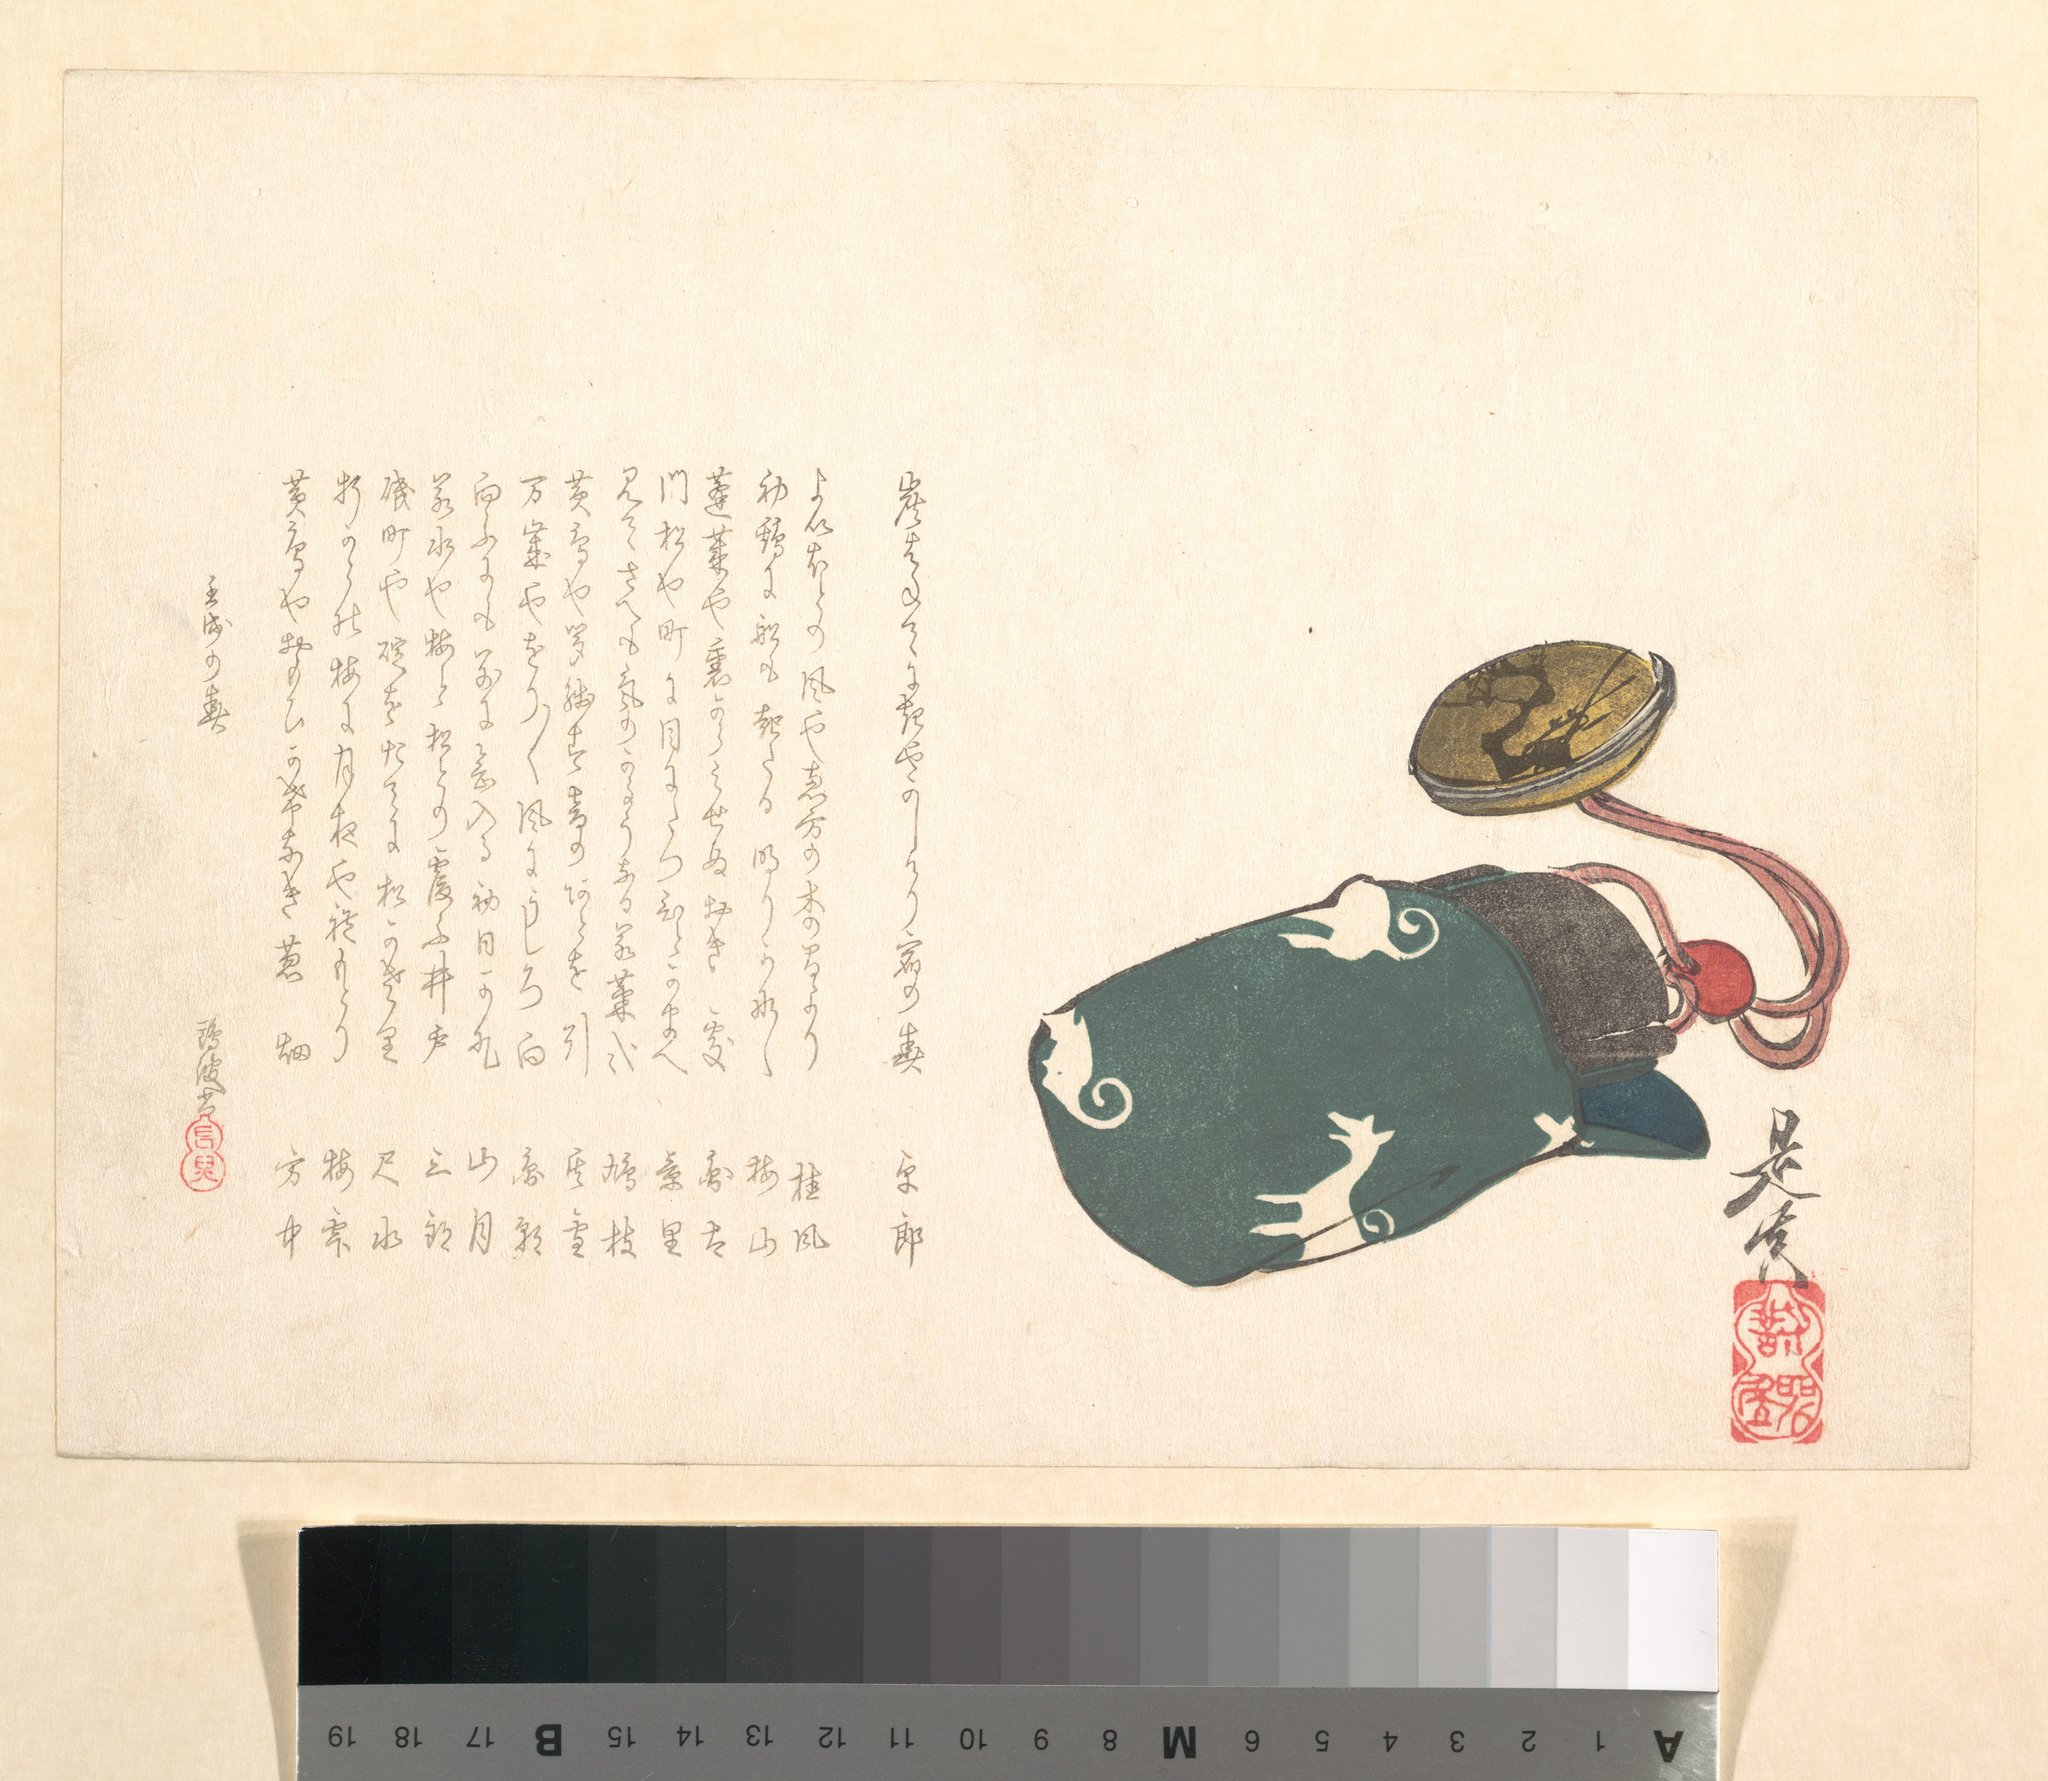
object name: print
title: Inrō Partly in a Green Bag with Pattern of White Foxes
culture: japanese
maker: shibata zeshin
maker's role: artist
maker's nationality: japanese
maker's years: 1807-1891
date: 1862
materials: ink, paper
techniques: surimono, woodblock print